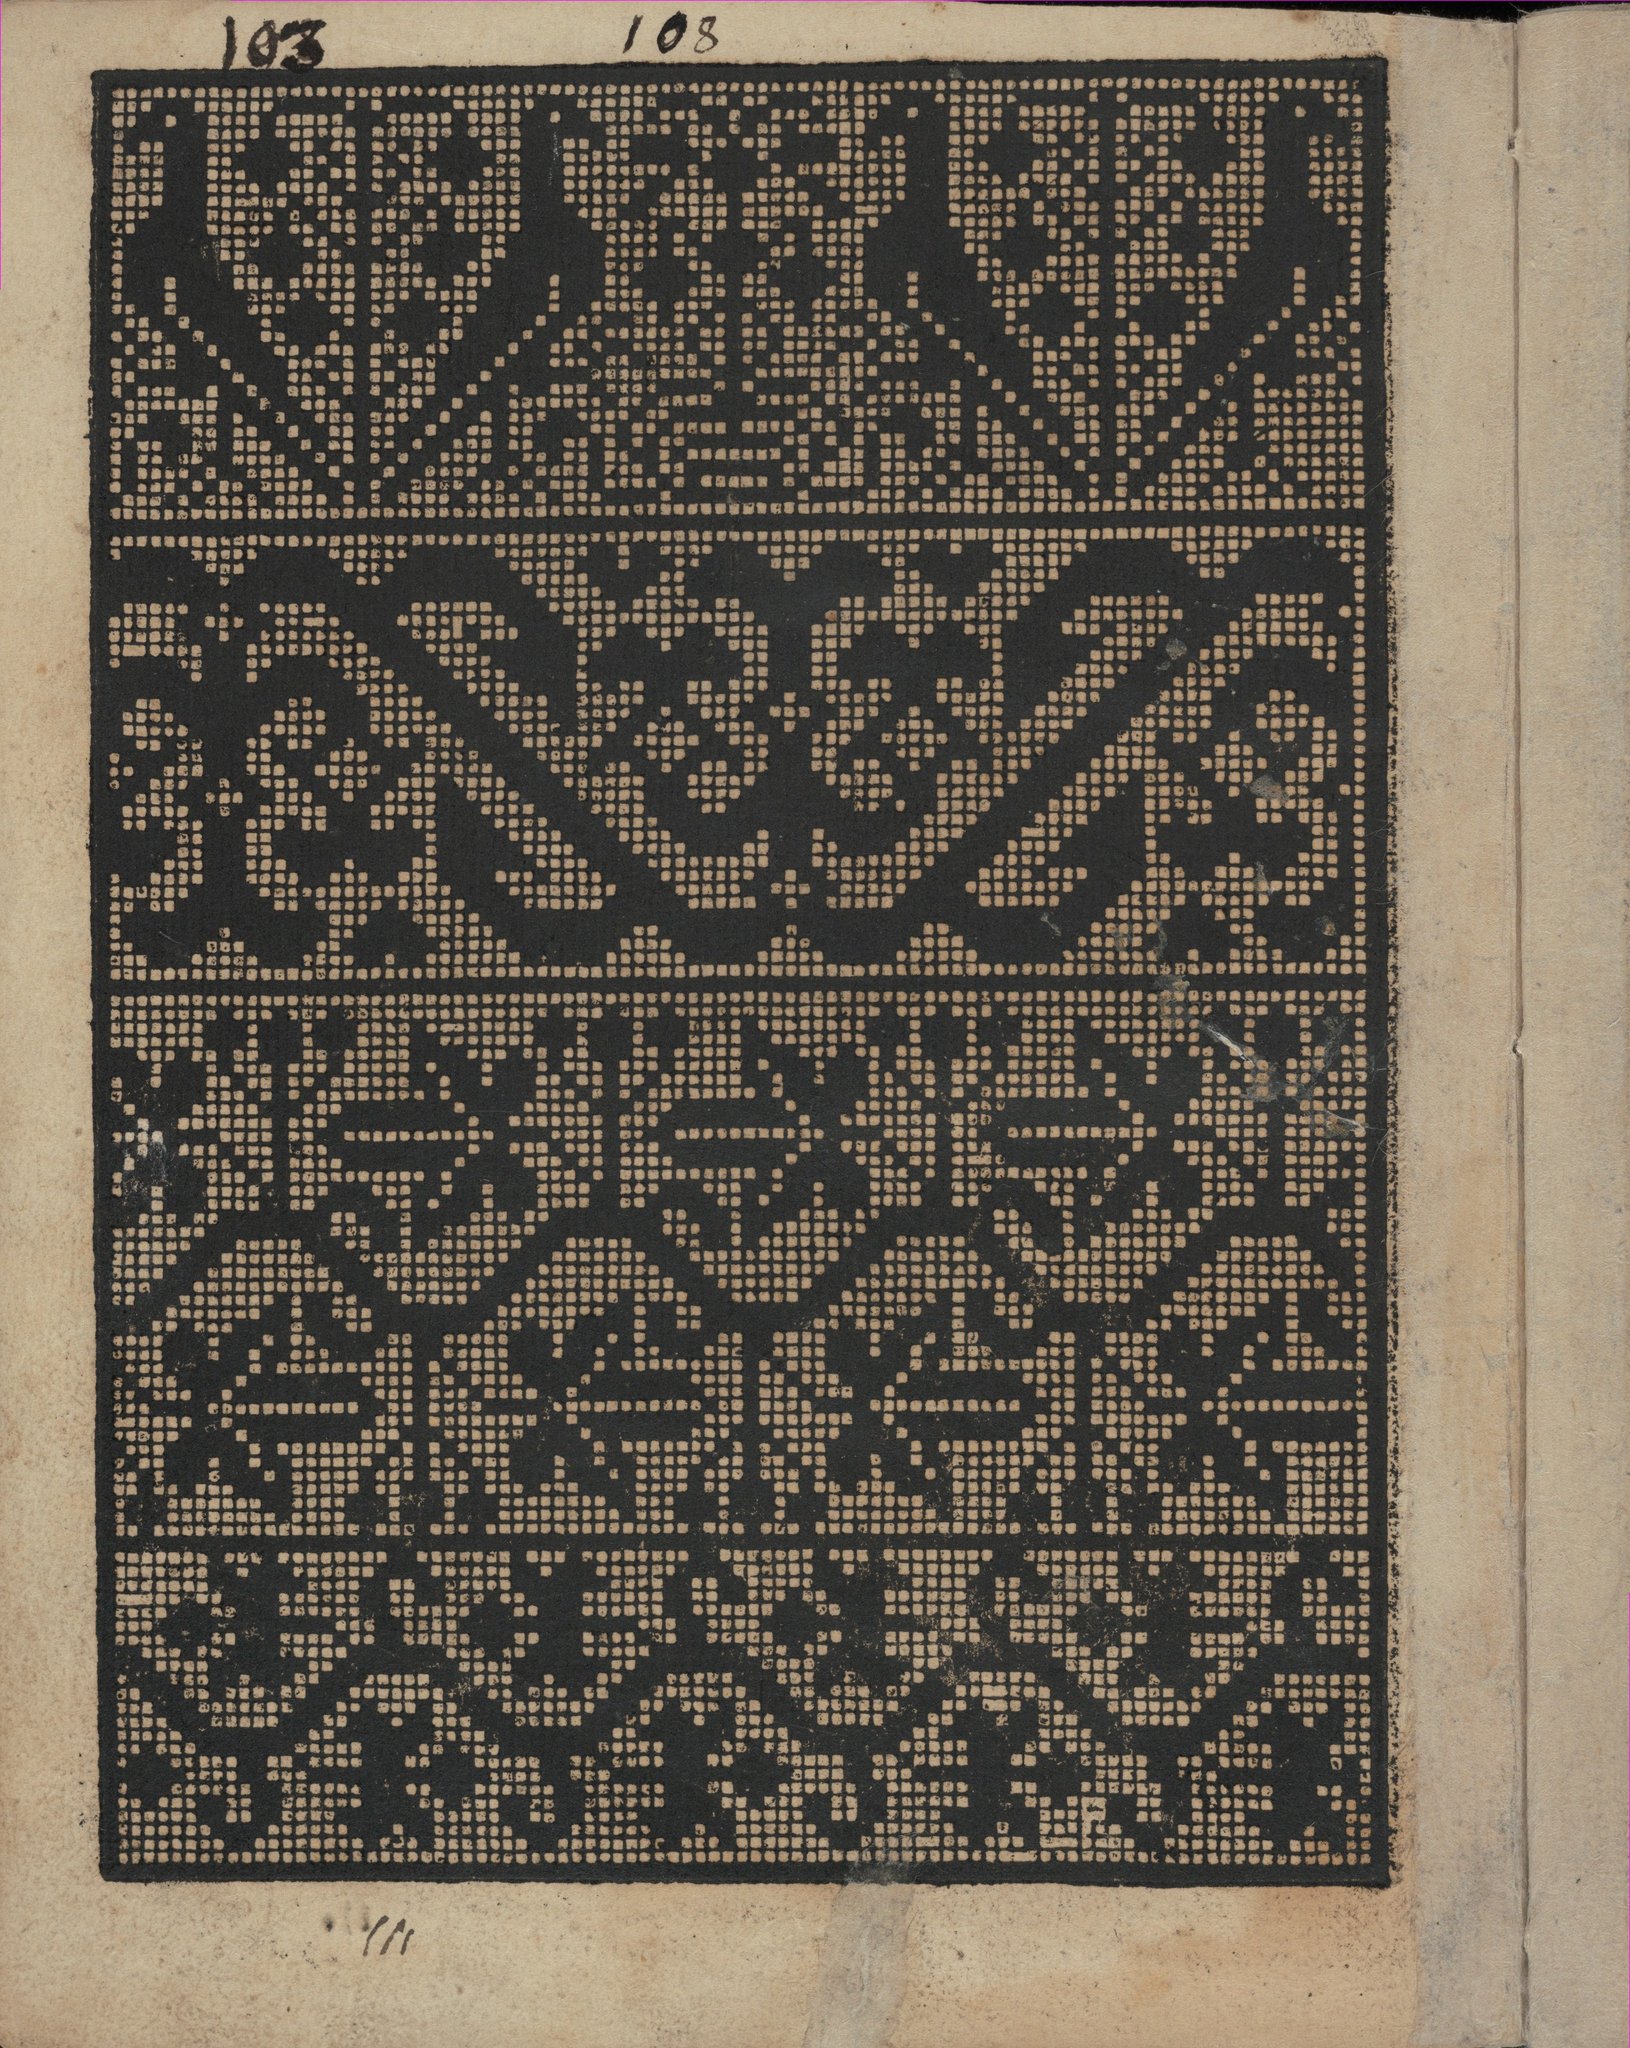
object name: book print ornament architecture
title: Libbretto nouellamete composto per maestro Domenico da Sera...lauorare di ogni sorte di punti, page 2 (verso)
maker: domenico da sera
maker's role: publisher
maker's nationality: french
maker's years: 1500-1599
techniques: woodcut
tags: birds,flowers